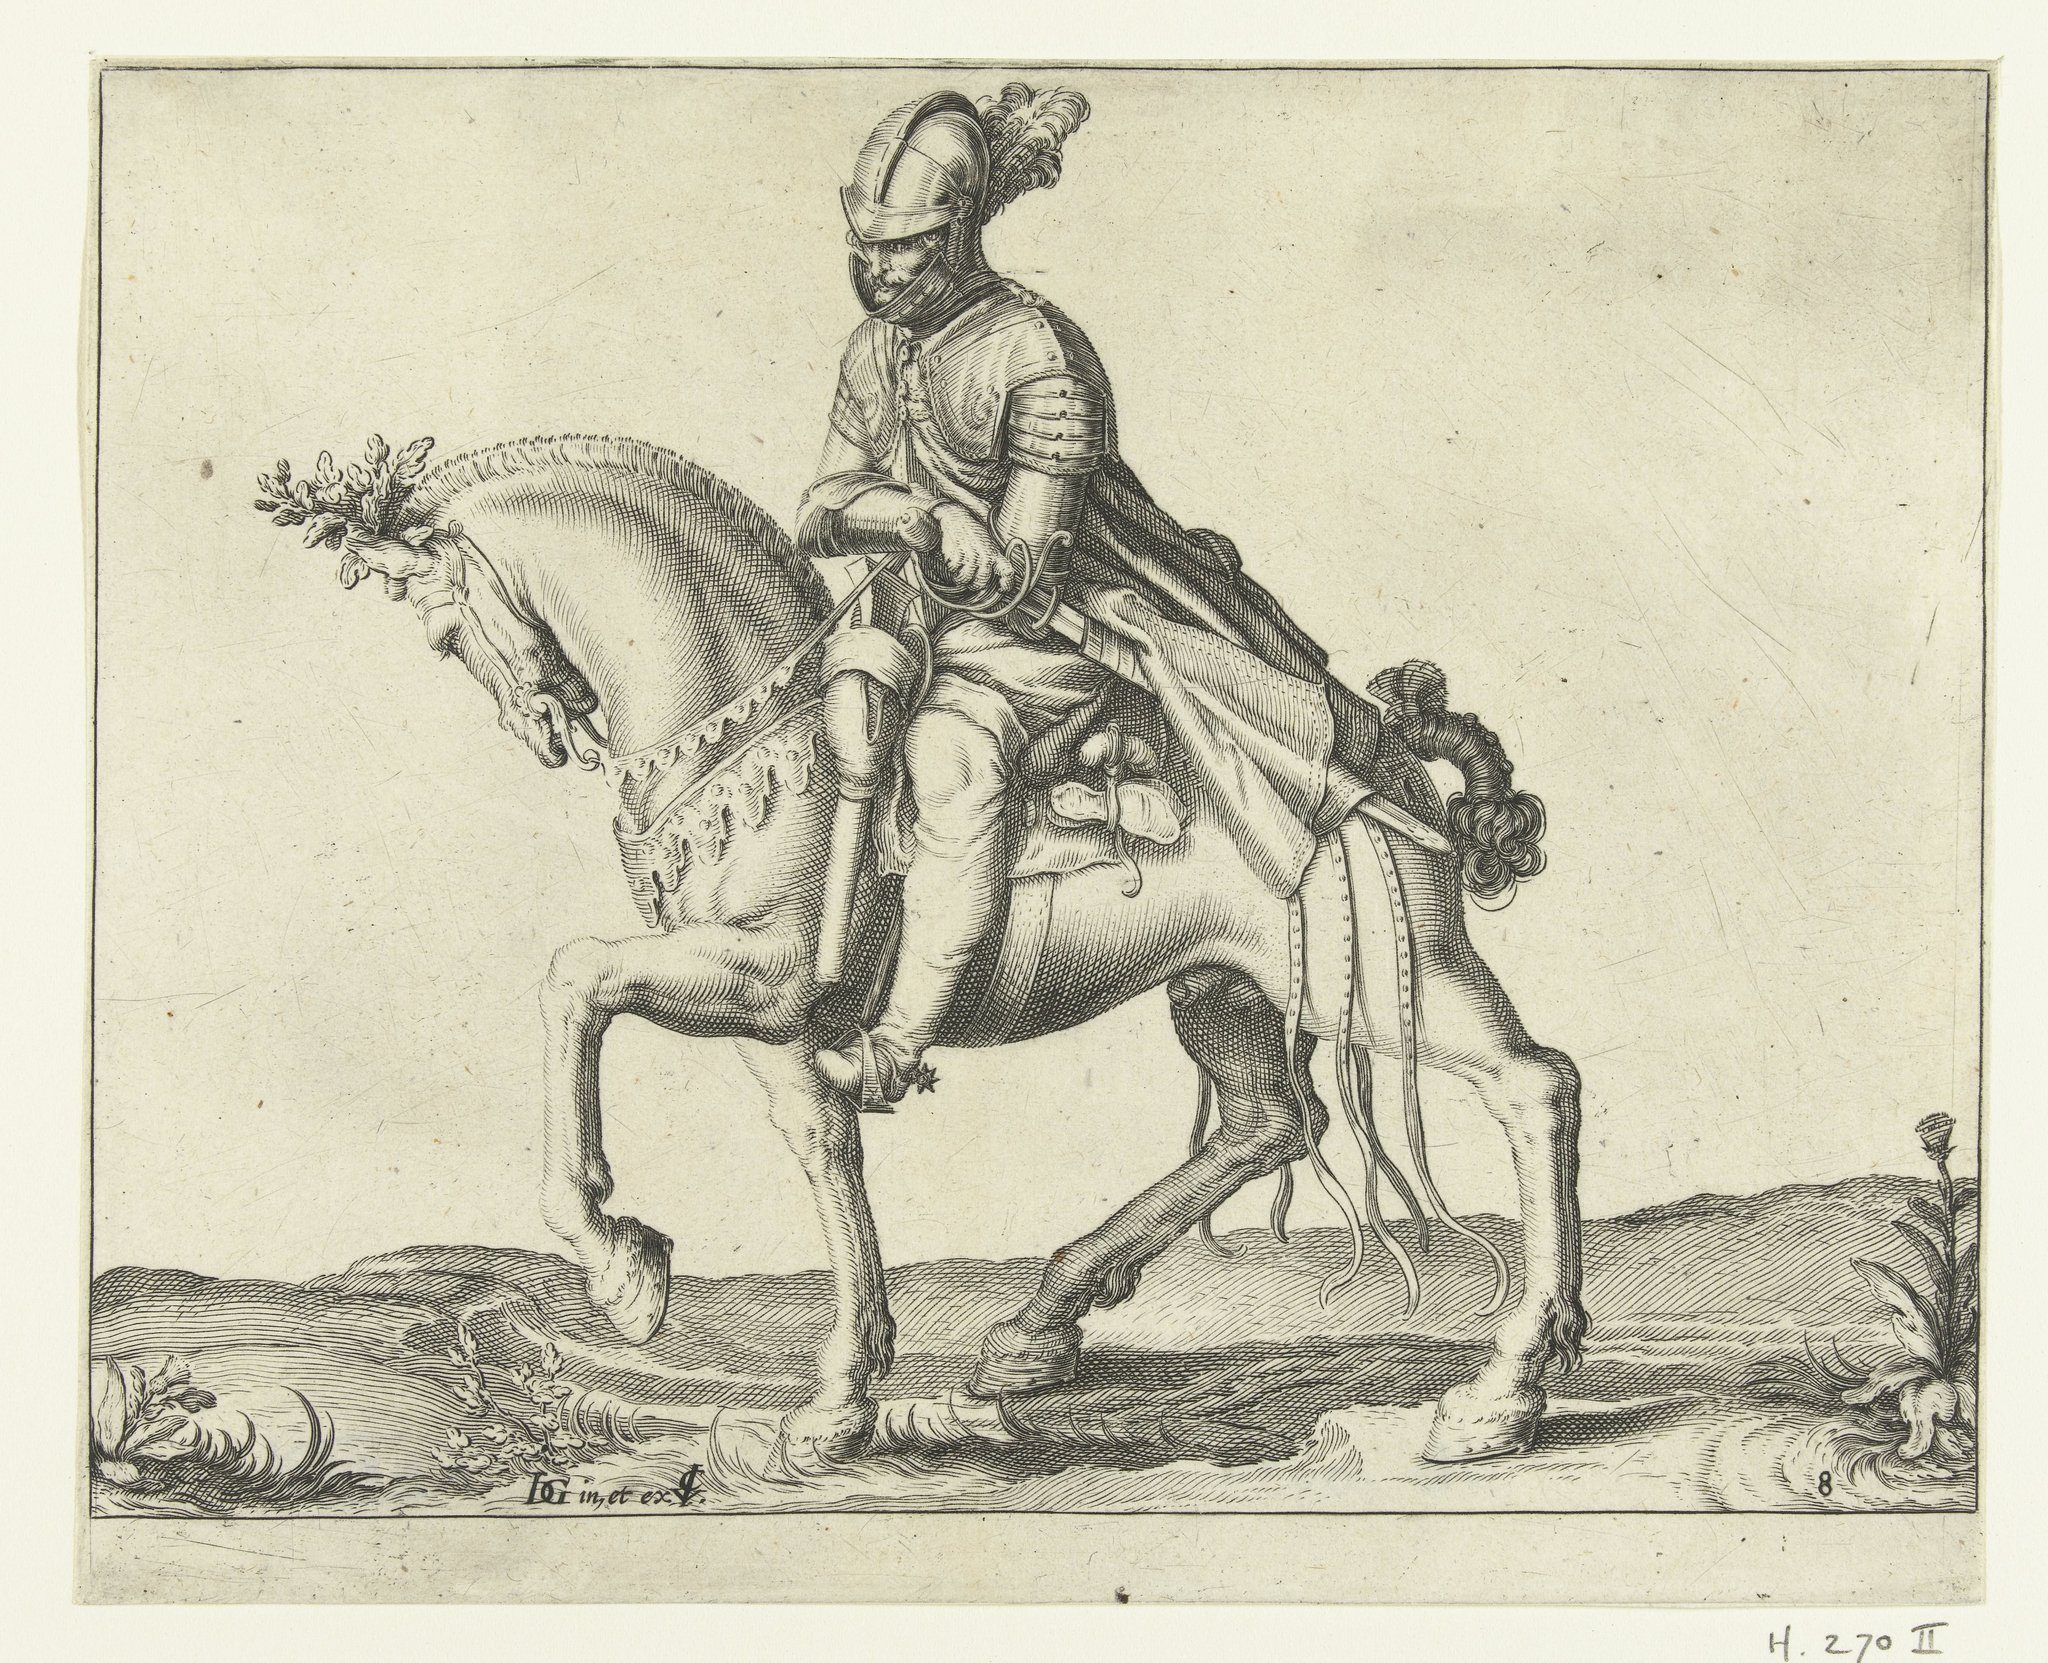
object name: print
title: Ruiter die zijn zwaard trekt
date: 1599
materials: paper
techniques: engraving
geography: leiden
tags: hacking and thrusting weapons: sword, warfare; military affairs (+ cavalry, horsemen)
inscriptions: collector's mark: Lugt 2228a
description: Een geharnaste man te paard, naar links rijdend, de rechterhand op het gevest van het zwaard aan zijn linkerzijde, om het te trekken. Deze prent is onderdeel van een serie van 22 genummerde prenten: een titelprent, 20 prenten waarop één of enkele verschillende typen (meest geharnaste) ruiters zijn weergegeven, en een prent met een ruitergevecht.